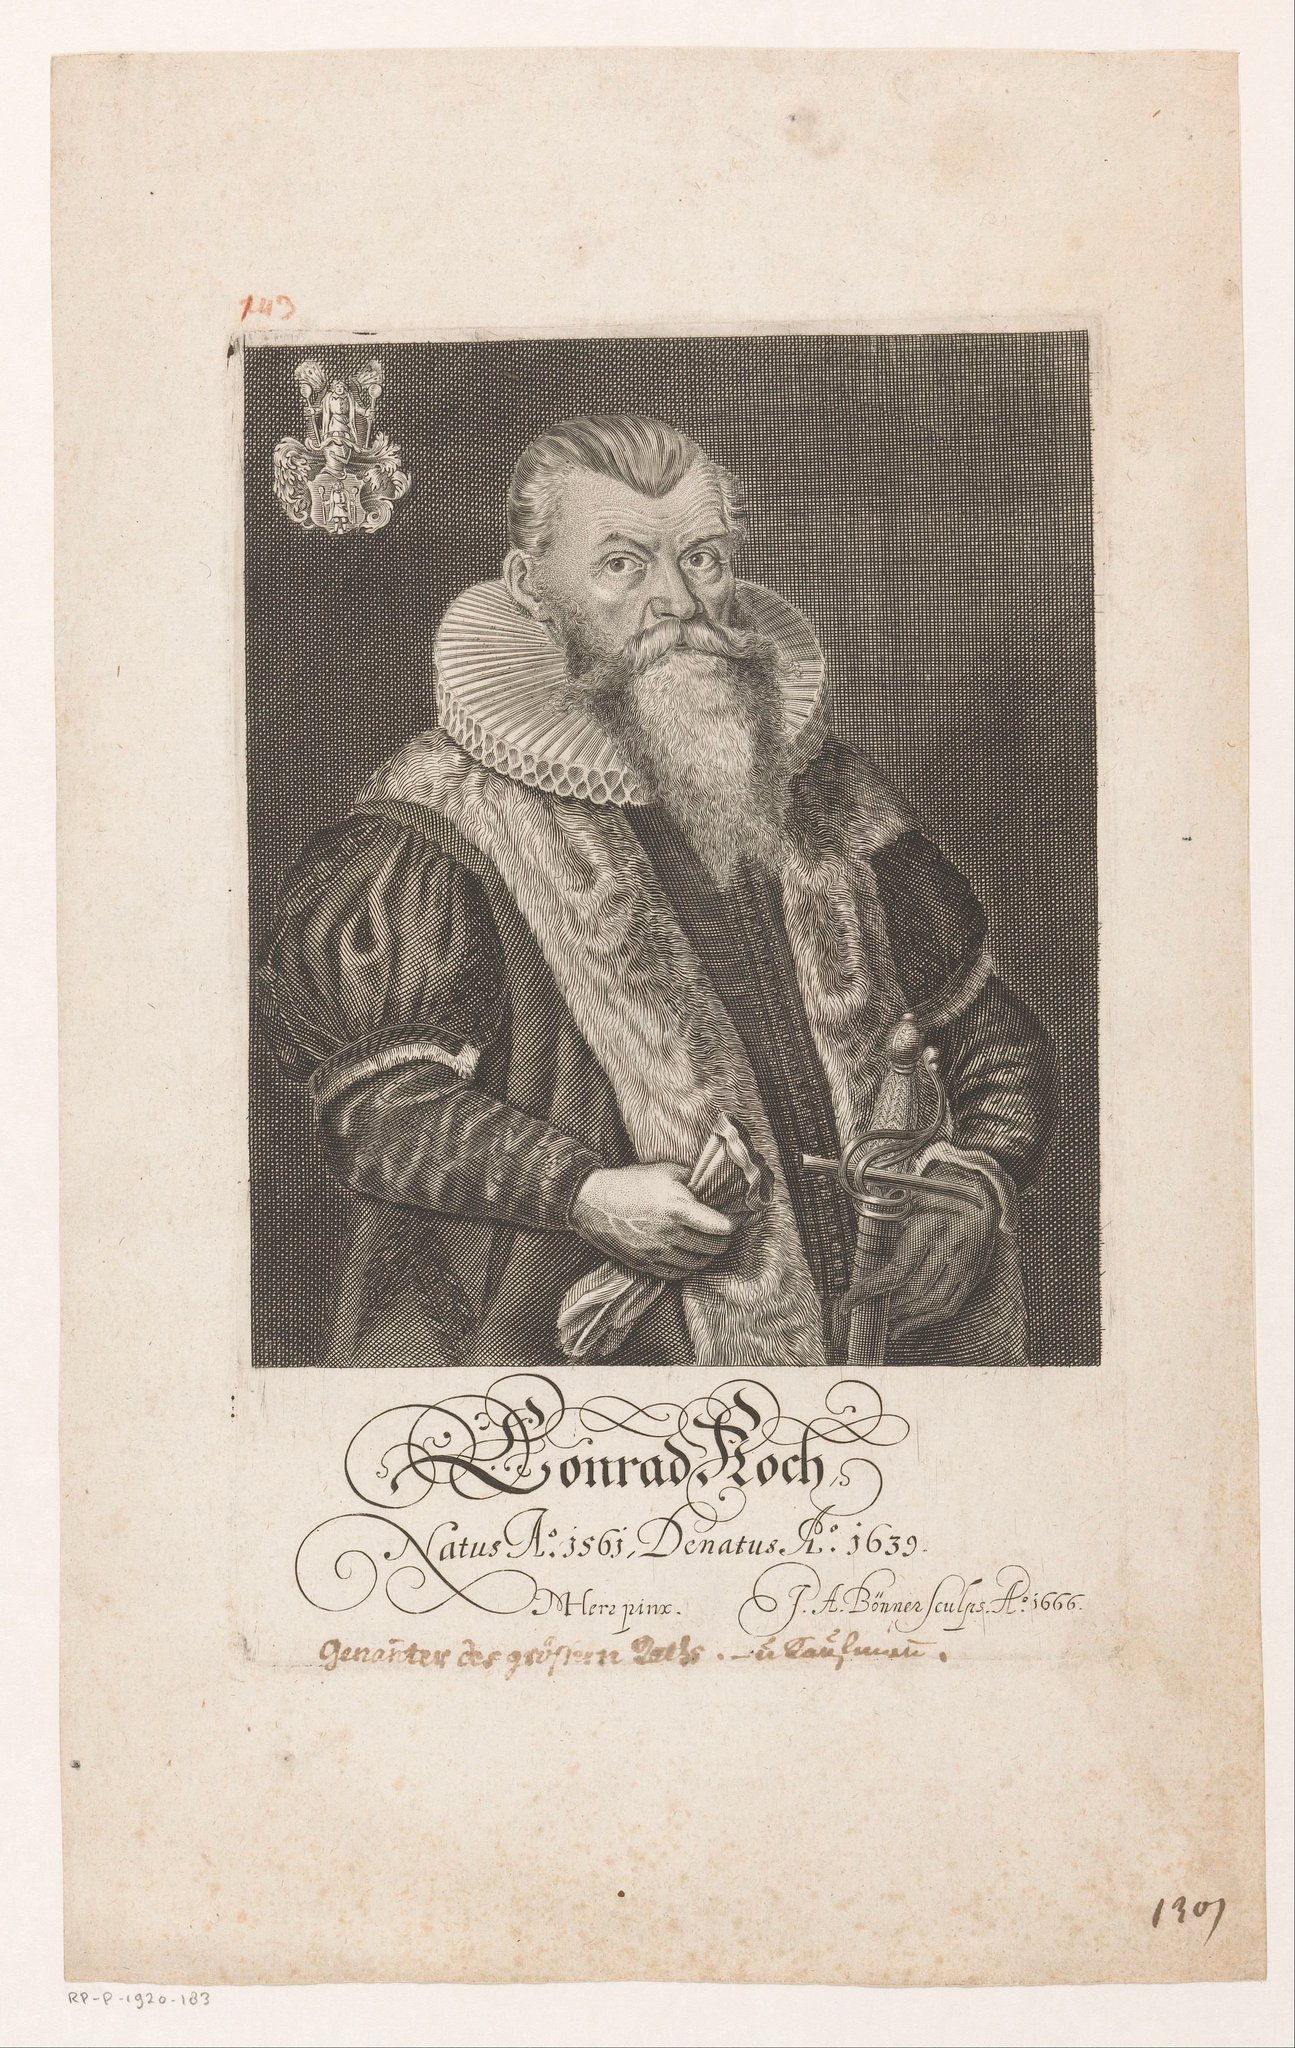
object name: print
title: Portret van Conrad Koch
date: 1666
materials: paper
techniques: engraving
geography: nuremberg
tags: gloves, mittens, etc., historical persons, hacking and thrusting weapons: sword, armorial bearing, heraldry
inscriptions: collector's mark: Lugt 2228, inscription: ‘genan[n]ter des grossen Rahts. - u[nd] Kaufmann (?)’